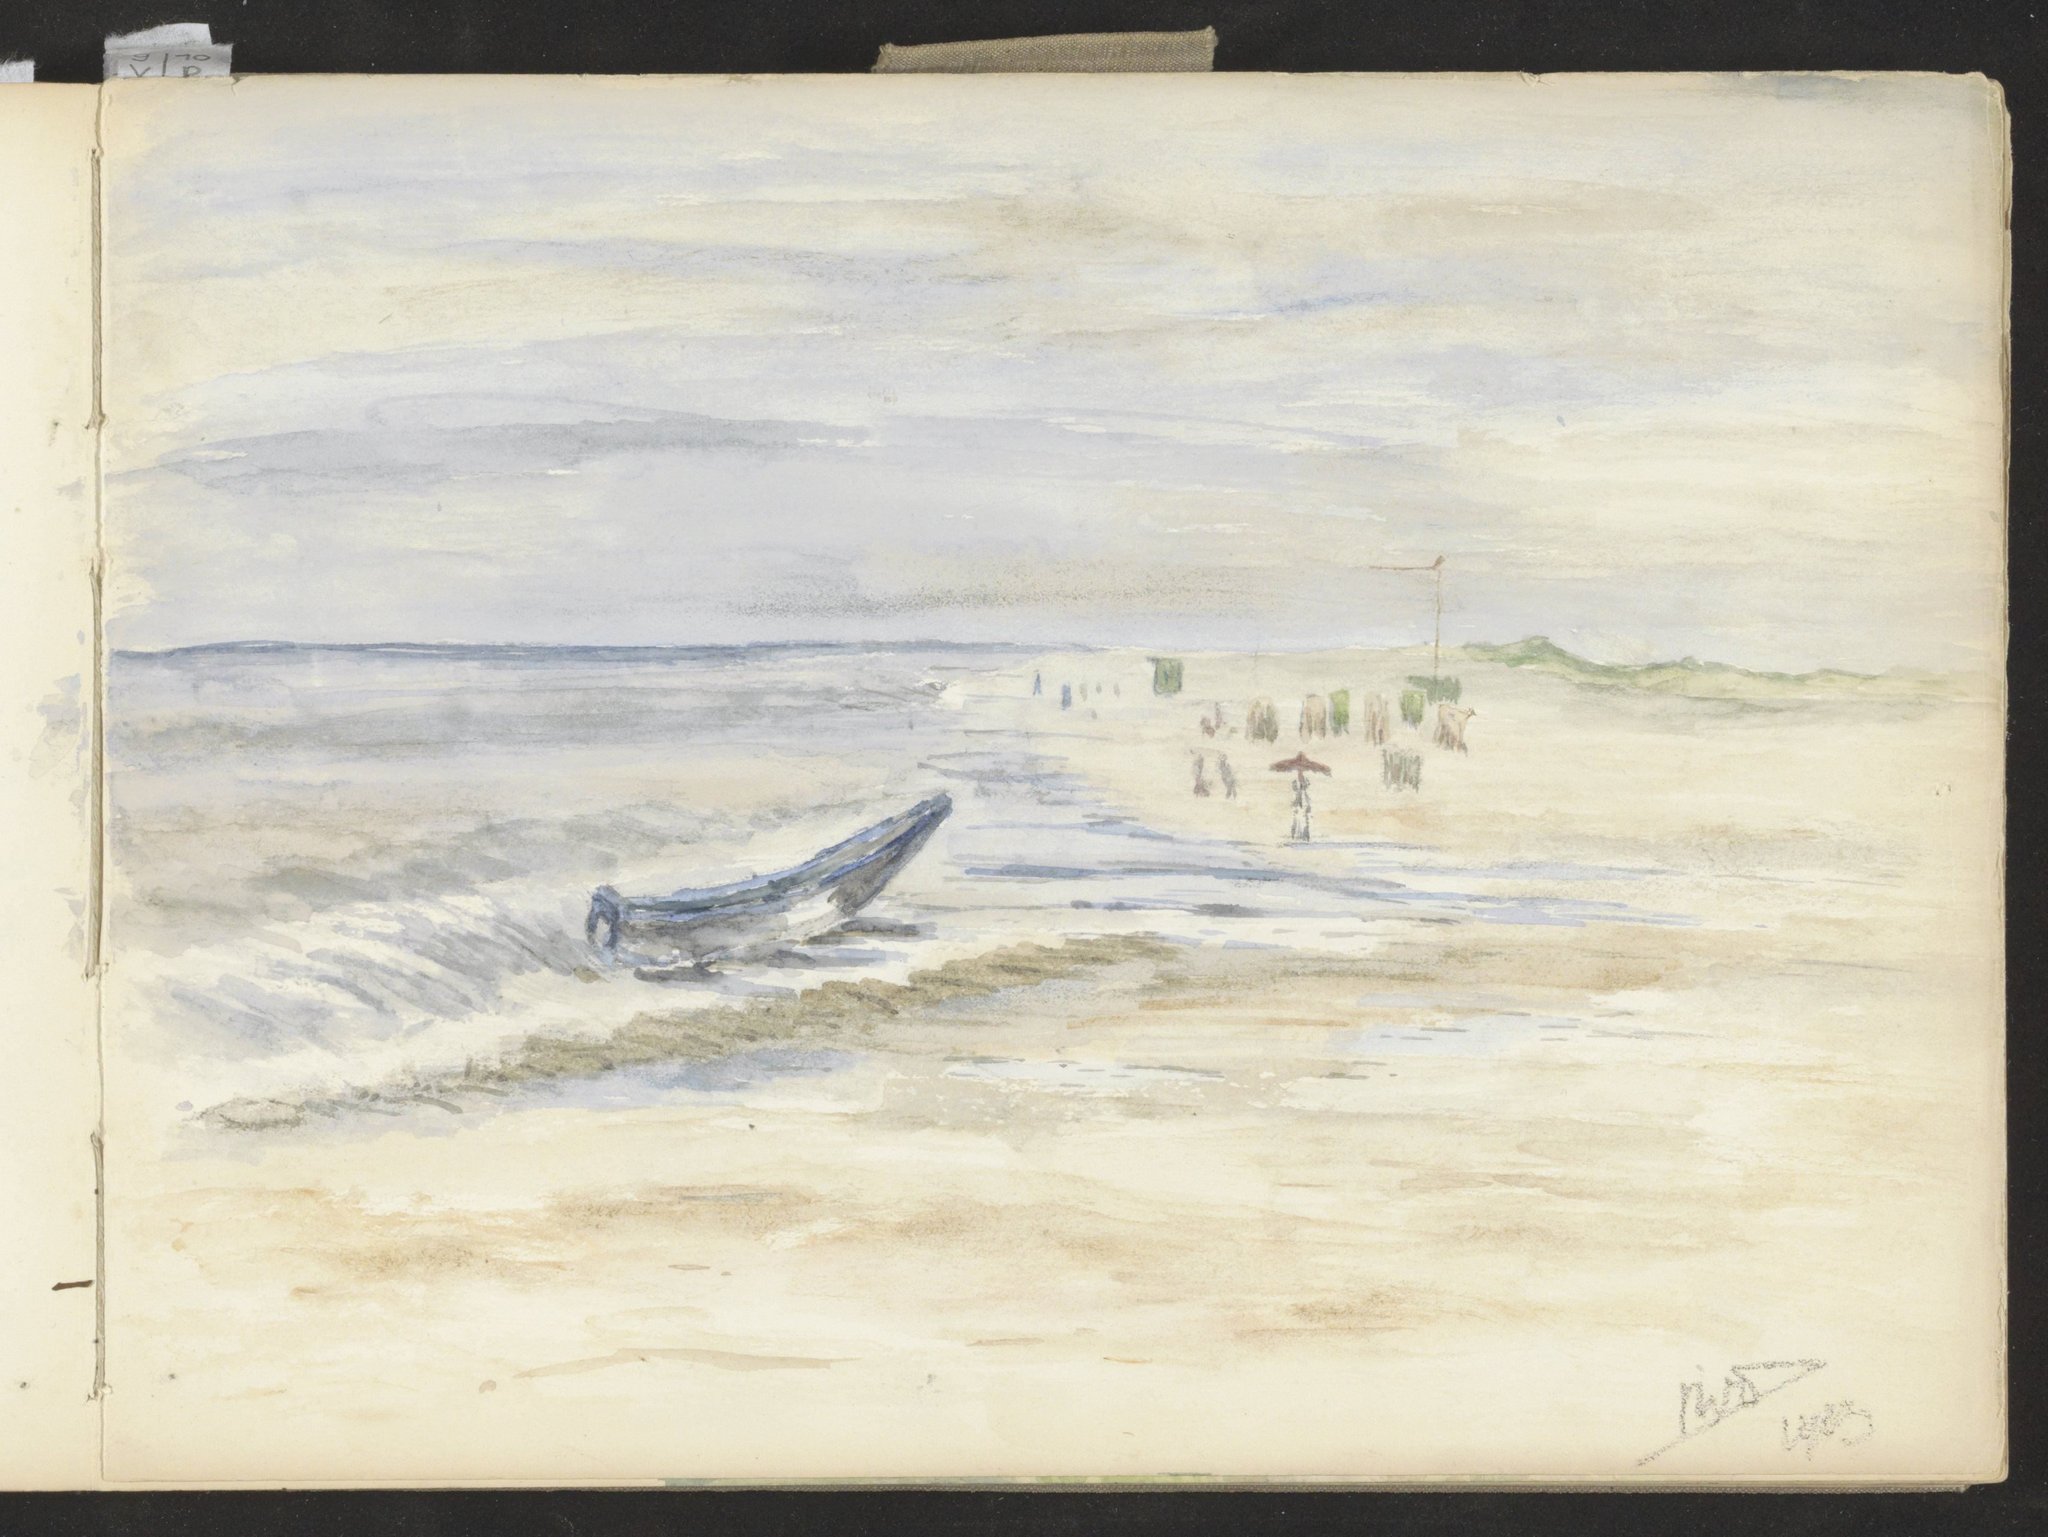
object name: sketchbook leaf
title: Gezicht op Bergen aan Zee met figuren en badkoetsen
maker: jonkheer johannes ludovicus paulus bosch van drakestein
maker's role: draughtsman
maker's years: 1865-1929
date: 1913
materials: paper, pencil, watercolor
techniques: brush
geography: bergen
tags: coast (+ landscape with figures, staffage)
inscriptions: signature and date: ‘LBvD/ 1913?’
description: Blad 7 recto uit een schetsboek met 47 bladen.